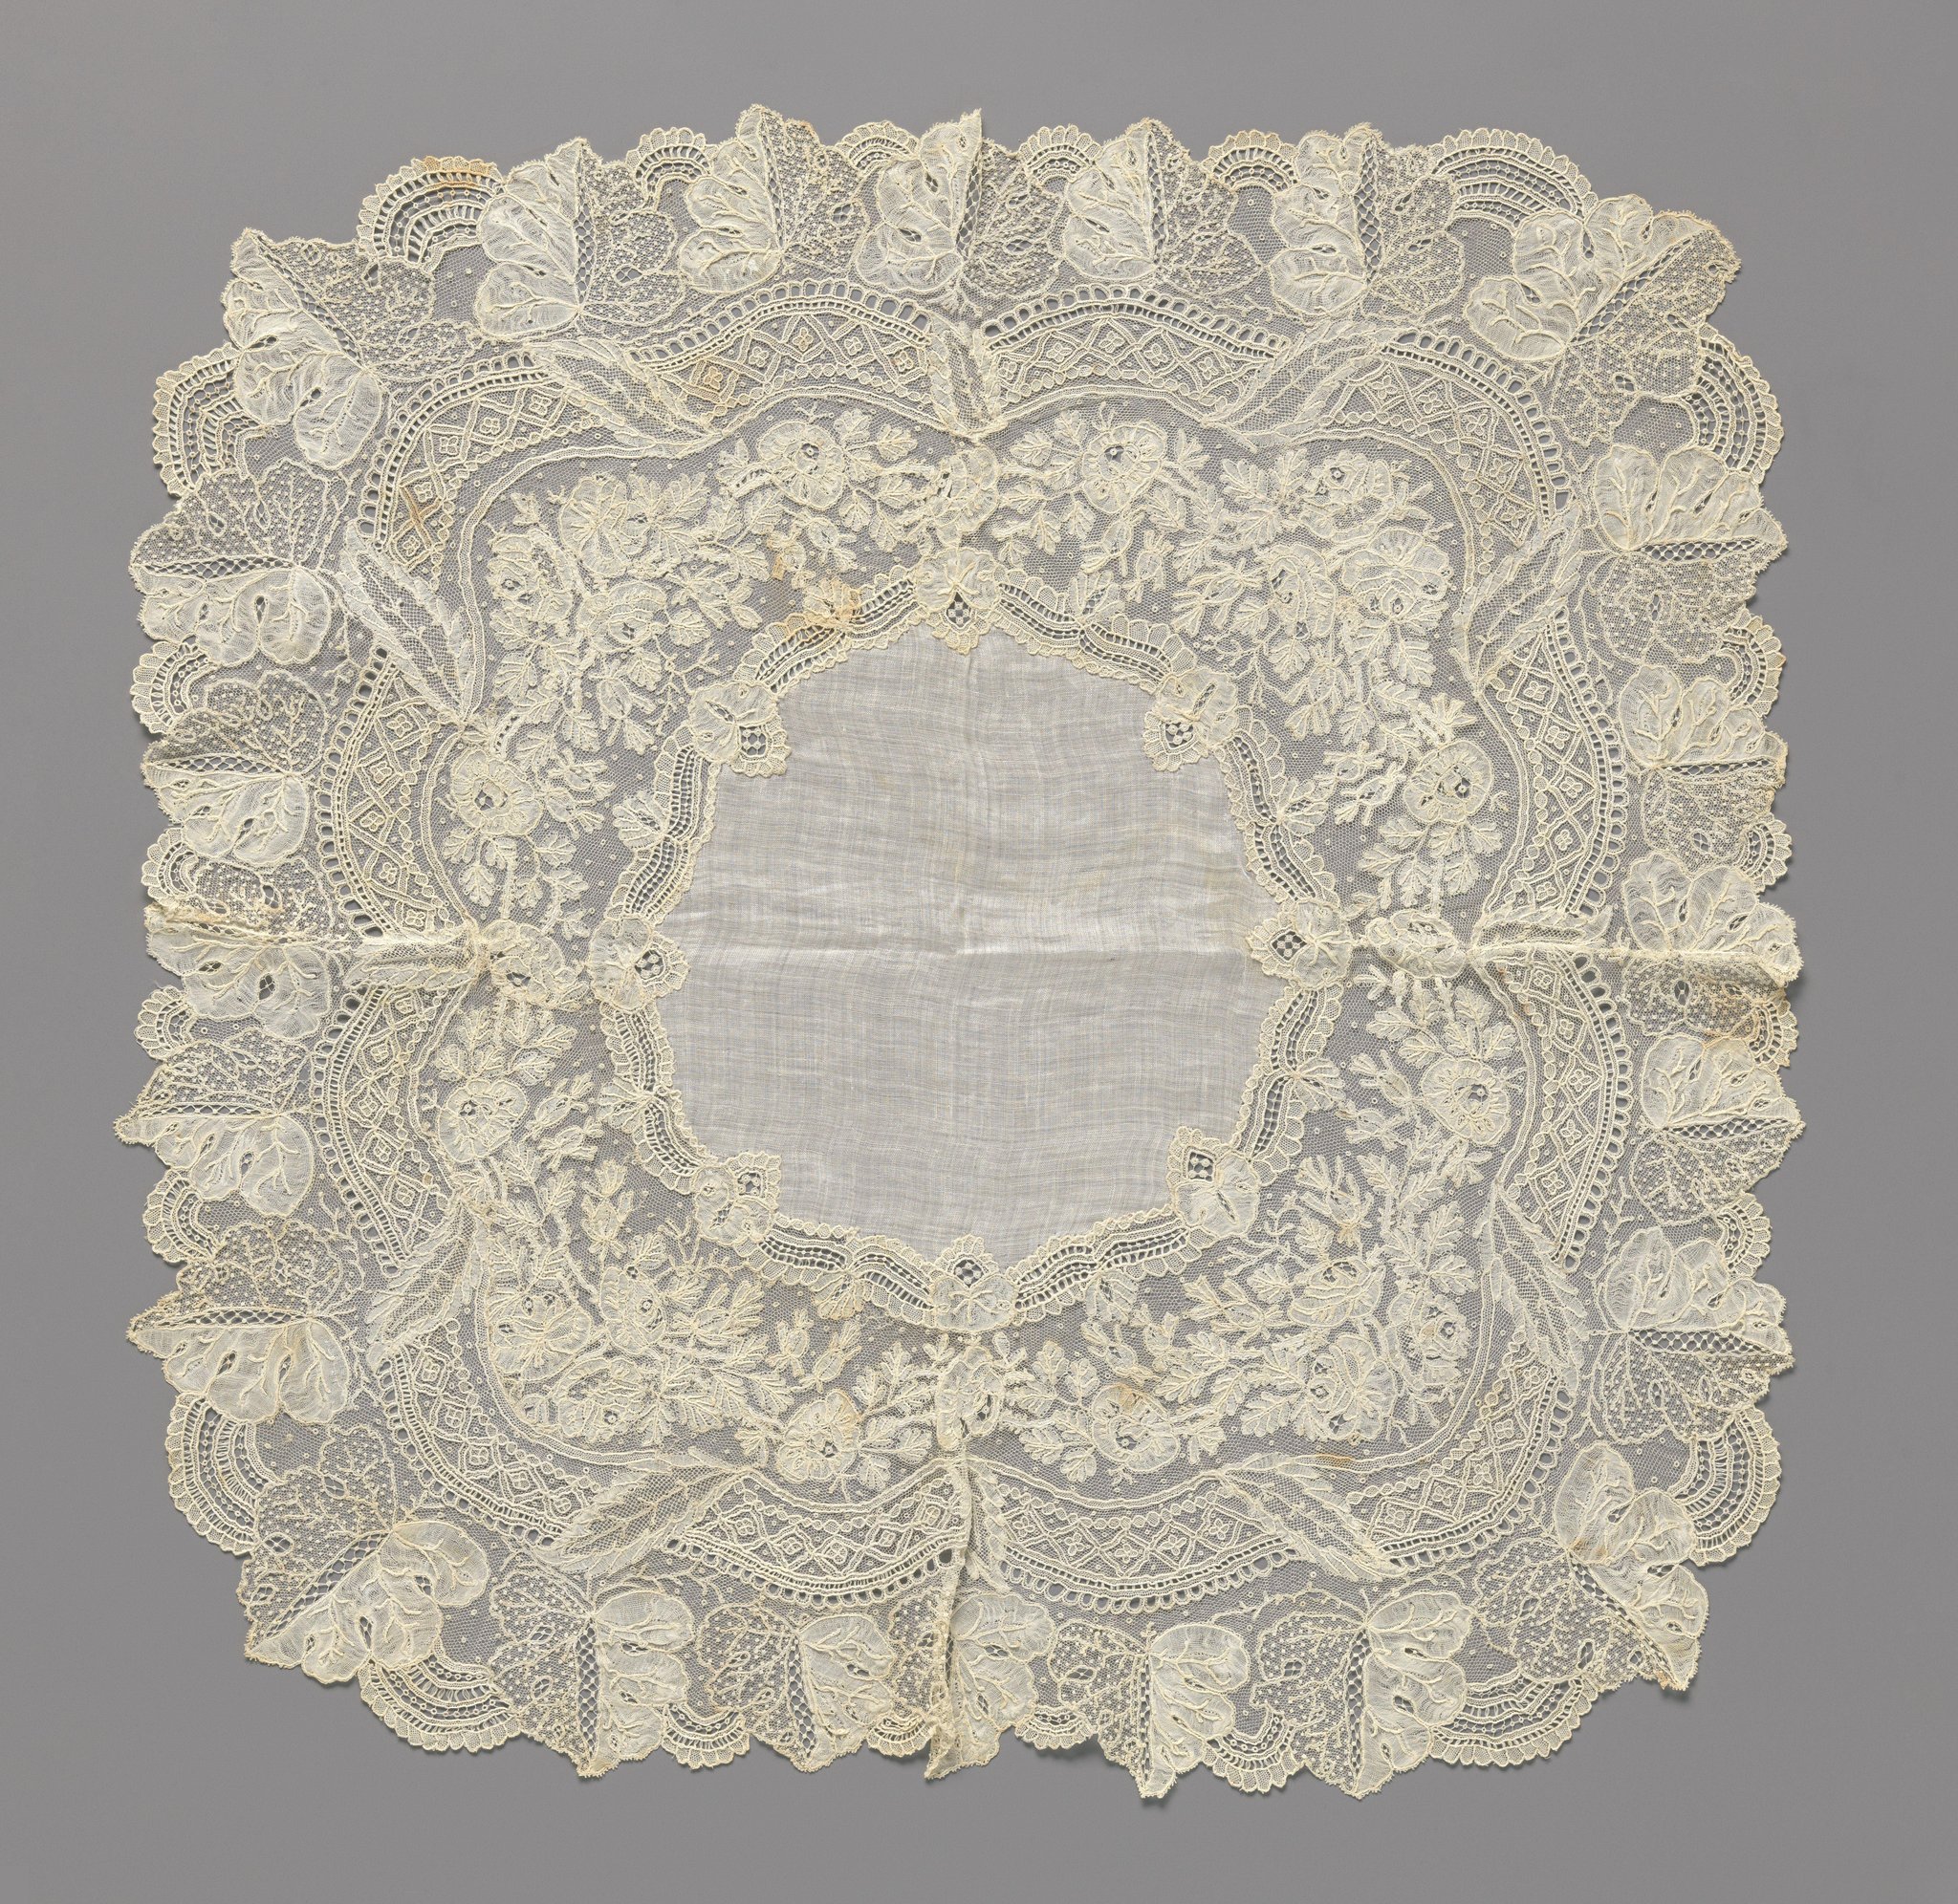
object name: handkerchief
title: Zakdoek van batist met rondom een rand gemengde kant met golvende sierrand met ruitjes rond rozentakken en een buitenrand met wingerdbladeren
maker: Anonymous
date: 1850-1870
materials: cotton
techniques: lace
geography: brussels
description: Zakdoek van batist met rondom een rand naturelkleurige gemengde kant: kloskant in combinatie met een naaldkantgrond en naaldkantmotieven. Vierkant model met afgeronde hoeken en een rond middenstuk van batist. Patroon met een ononderbroken golvende slinger van rozen en rozenknoppen (duchesse-kloskant met een naaldkantgrond). Hier omheen loopt een golvende sierband met ruitjes en parelrandje (naaldkant, Brusselse gaaskant). De buitenrand is grotendeels van naaldkant met een patroon van straalsgewijs geschulpte wingerdbladeren, die half mat, half gespikkeld gevuld zijn. De matte delen zijn geklost. De gekloste delen zijn gemaakt in linnenslag en voorzien van reliëfcontouren. In de gekloste rozen is zeer spaarzaam netslag gebruikt.